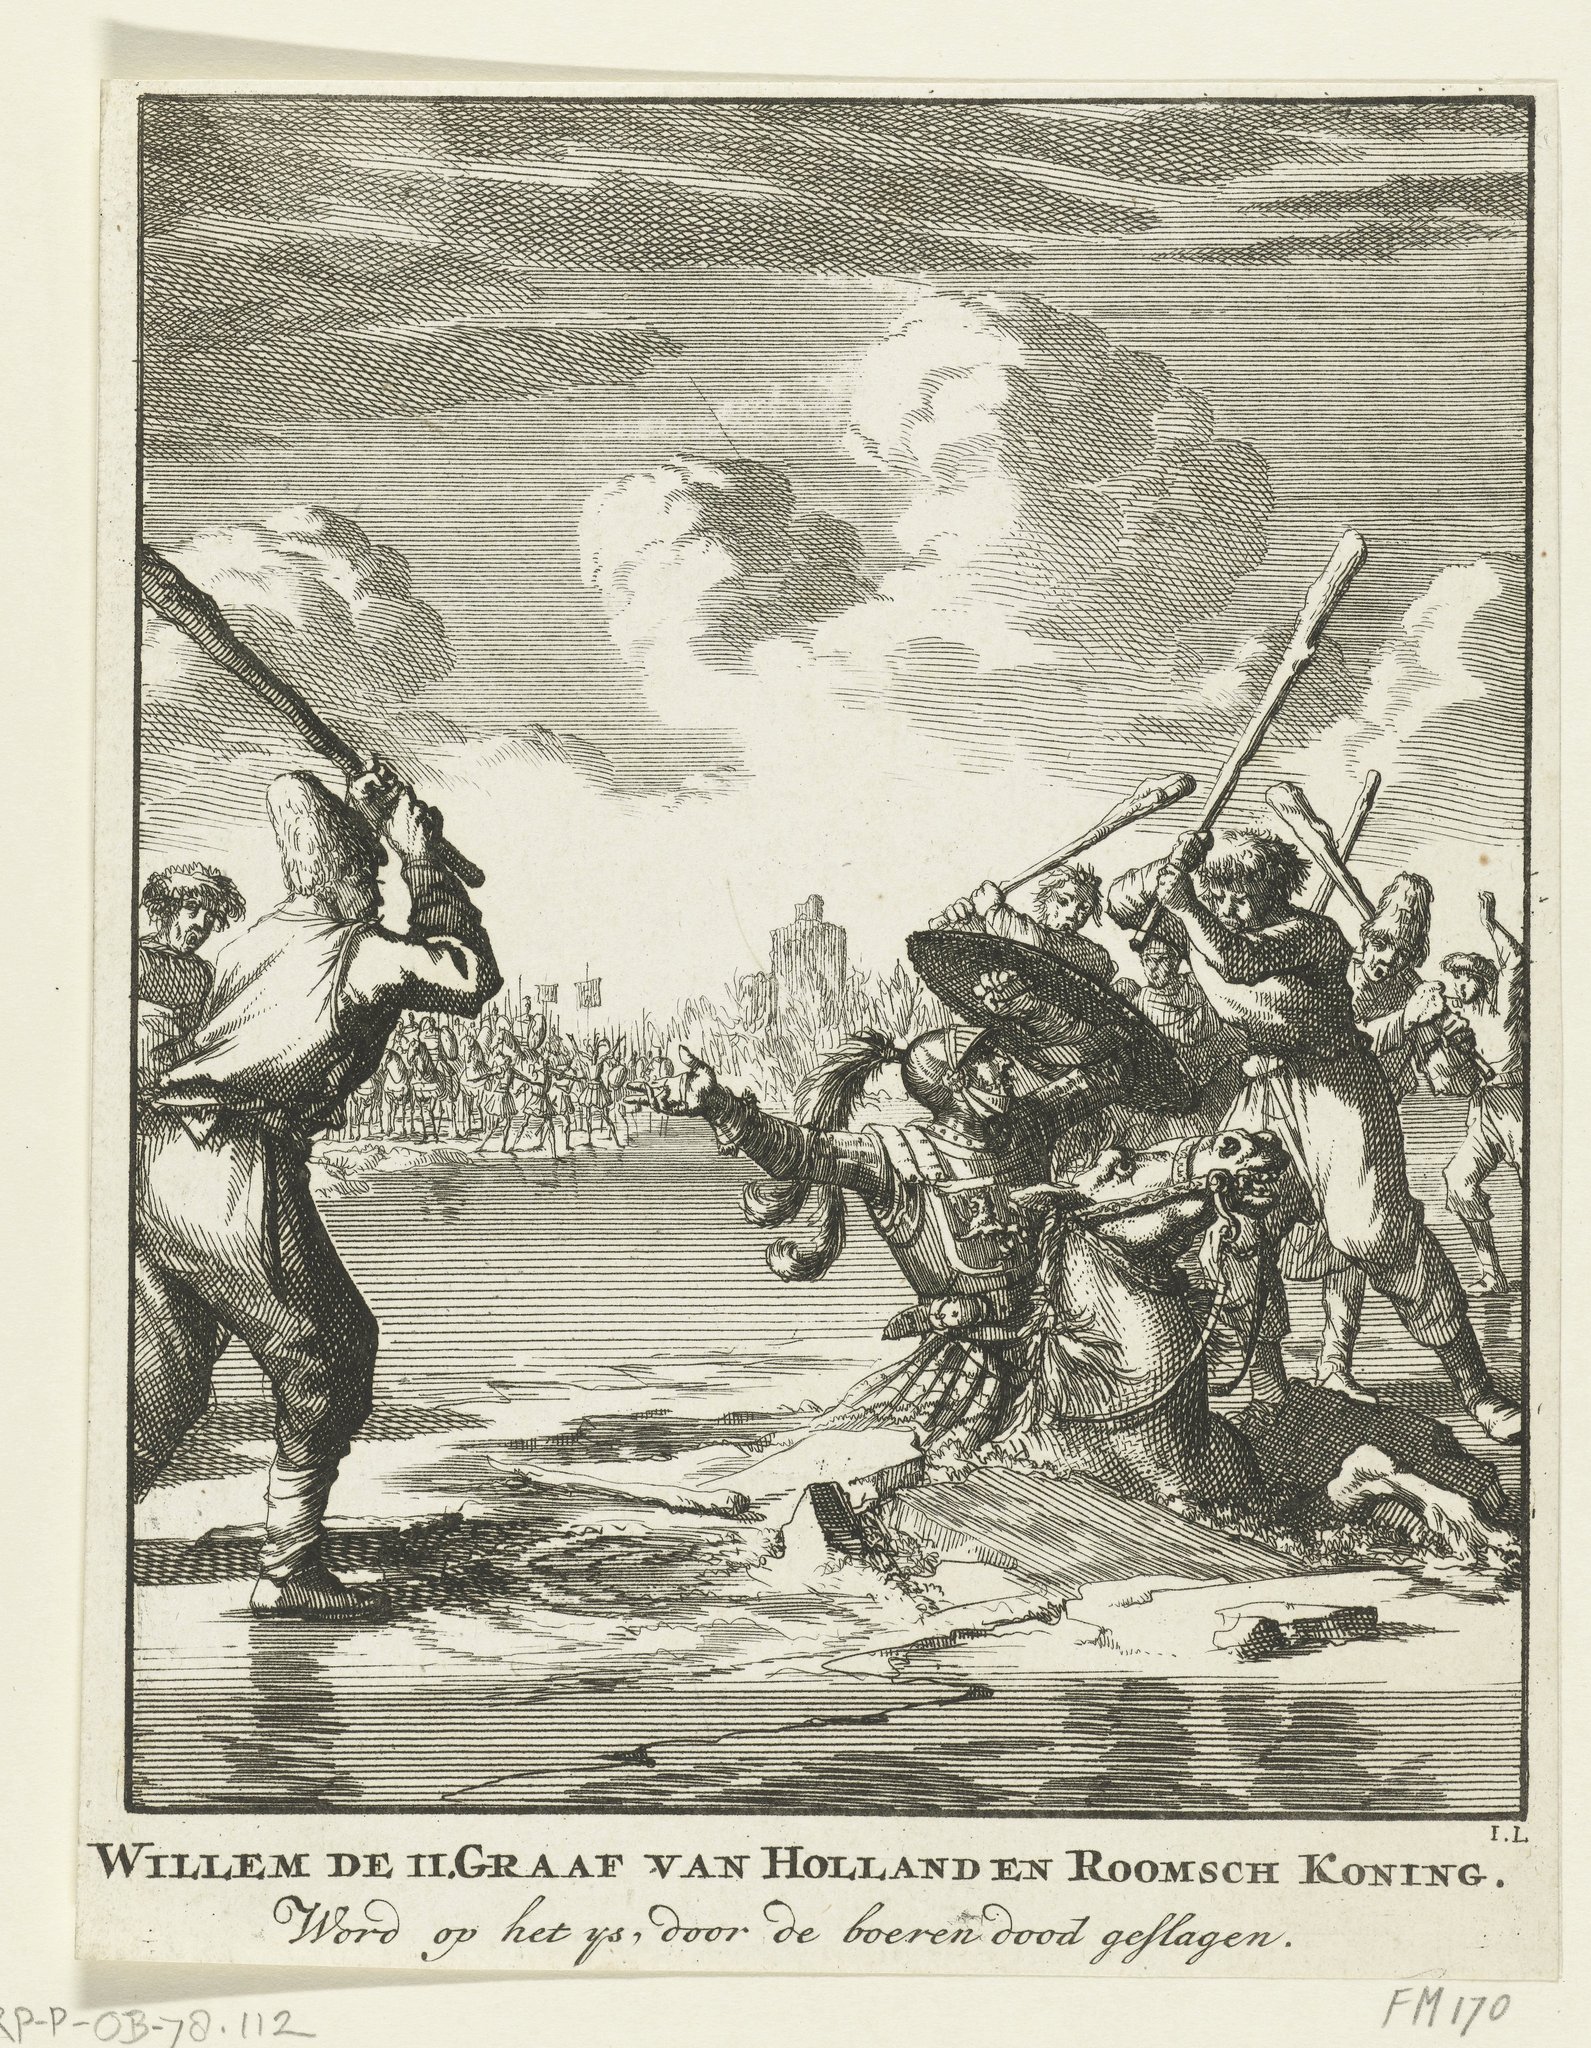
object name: history print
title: Graaf Willem II zakt bij Hoogwoud door het ijs, 1256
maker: jan luyken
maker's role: draughtsman, print maker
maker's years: 1649-1712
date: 1660-1712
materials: paper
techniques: etching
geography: northern netherlands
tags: earl, violent death, being killed; being mishandled and maltreated; seeking death, attempt, political murder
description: Graaf Willem II zakt bij Hoogwoud door het ijs van het Berkmeer en wordt door de Westfriezen gedood, 28 januari 1256. De graaf in harnas te paard zakt door het ijs en wordt doodgeslagen door woeste boeren met knuppels.